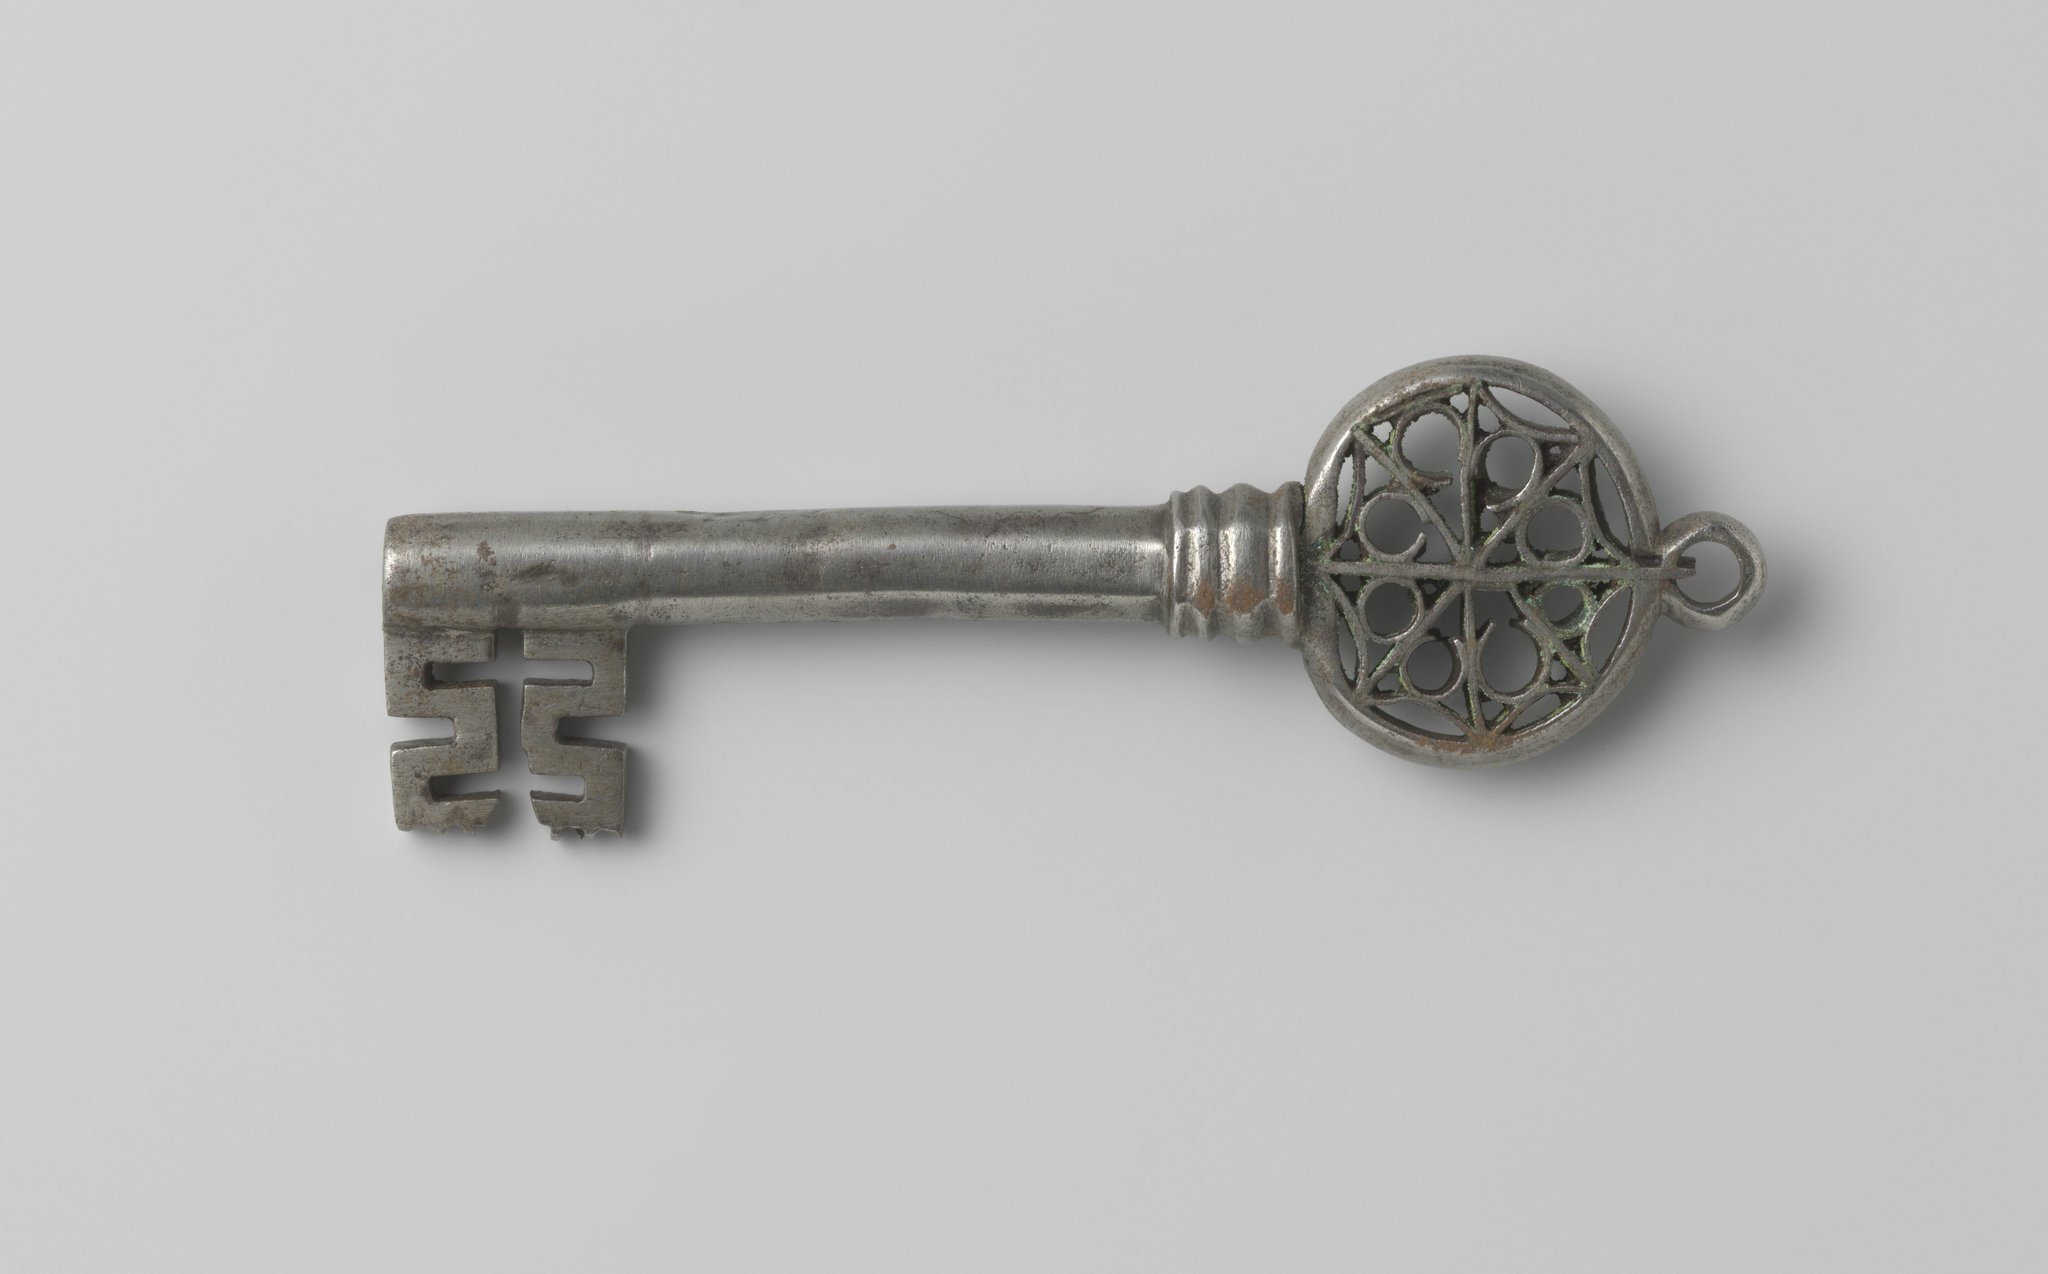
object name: key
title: Sleutel van ijzer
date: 1500-1600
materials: iron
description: IJzeren sleutel met opengewerkt oog en vierkante baard, geheel uit de hand gesmeed.